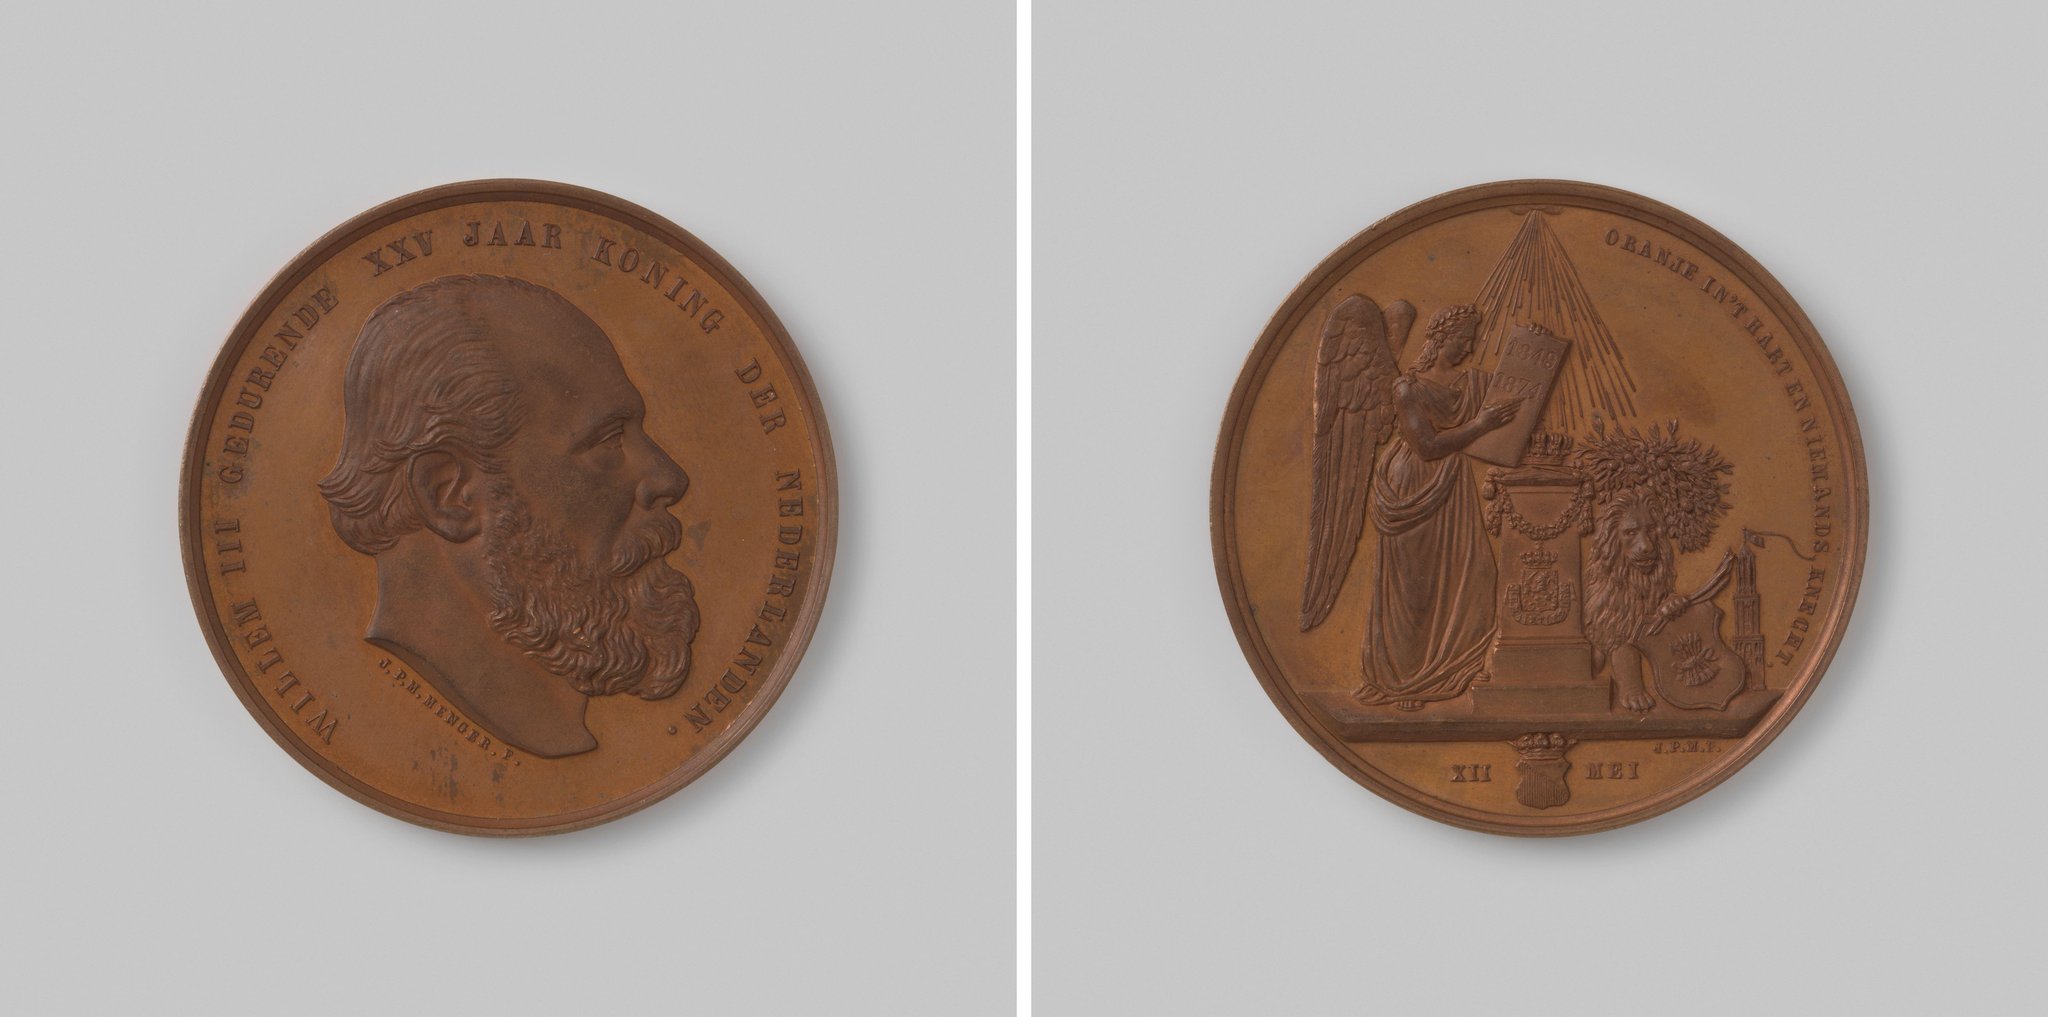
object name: history medal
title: Vijfentwintigjarig regeringsjubileum van Koning Willem III gevierd te Utrecht 1874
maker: johan philip mathias menger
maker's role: medailleur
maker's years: 1845-1905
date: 1874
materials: bronze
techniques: striking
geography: utrecht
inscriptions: factory mark: ‘mercuriusstaf’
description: Bronzen penning, op de voorzijde het portret van Willem III naar rechts met omschrift, op de keerzijde een gevleugelde vrouw die de jaartallen 1849 en 1874 op een geschiedtafel schrijft, naast een altaar waarop een kroon, een oranjeboom en een leeuw met het Nederlands wapenschild, alles onder een stralend hemellicht, aan de rechterzijde omschrift en in afsnede tekst en een gekroond Utrechts stadswapenschildje.